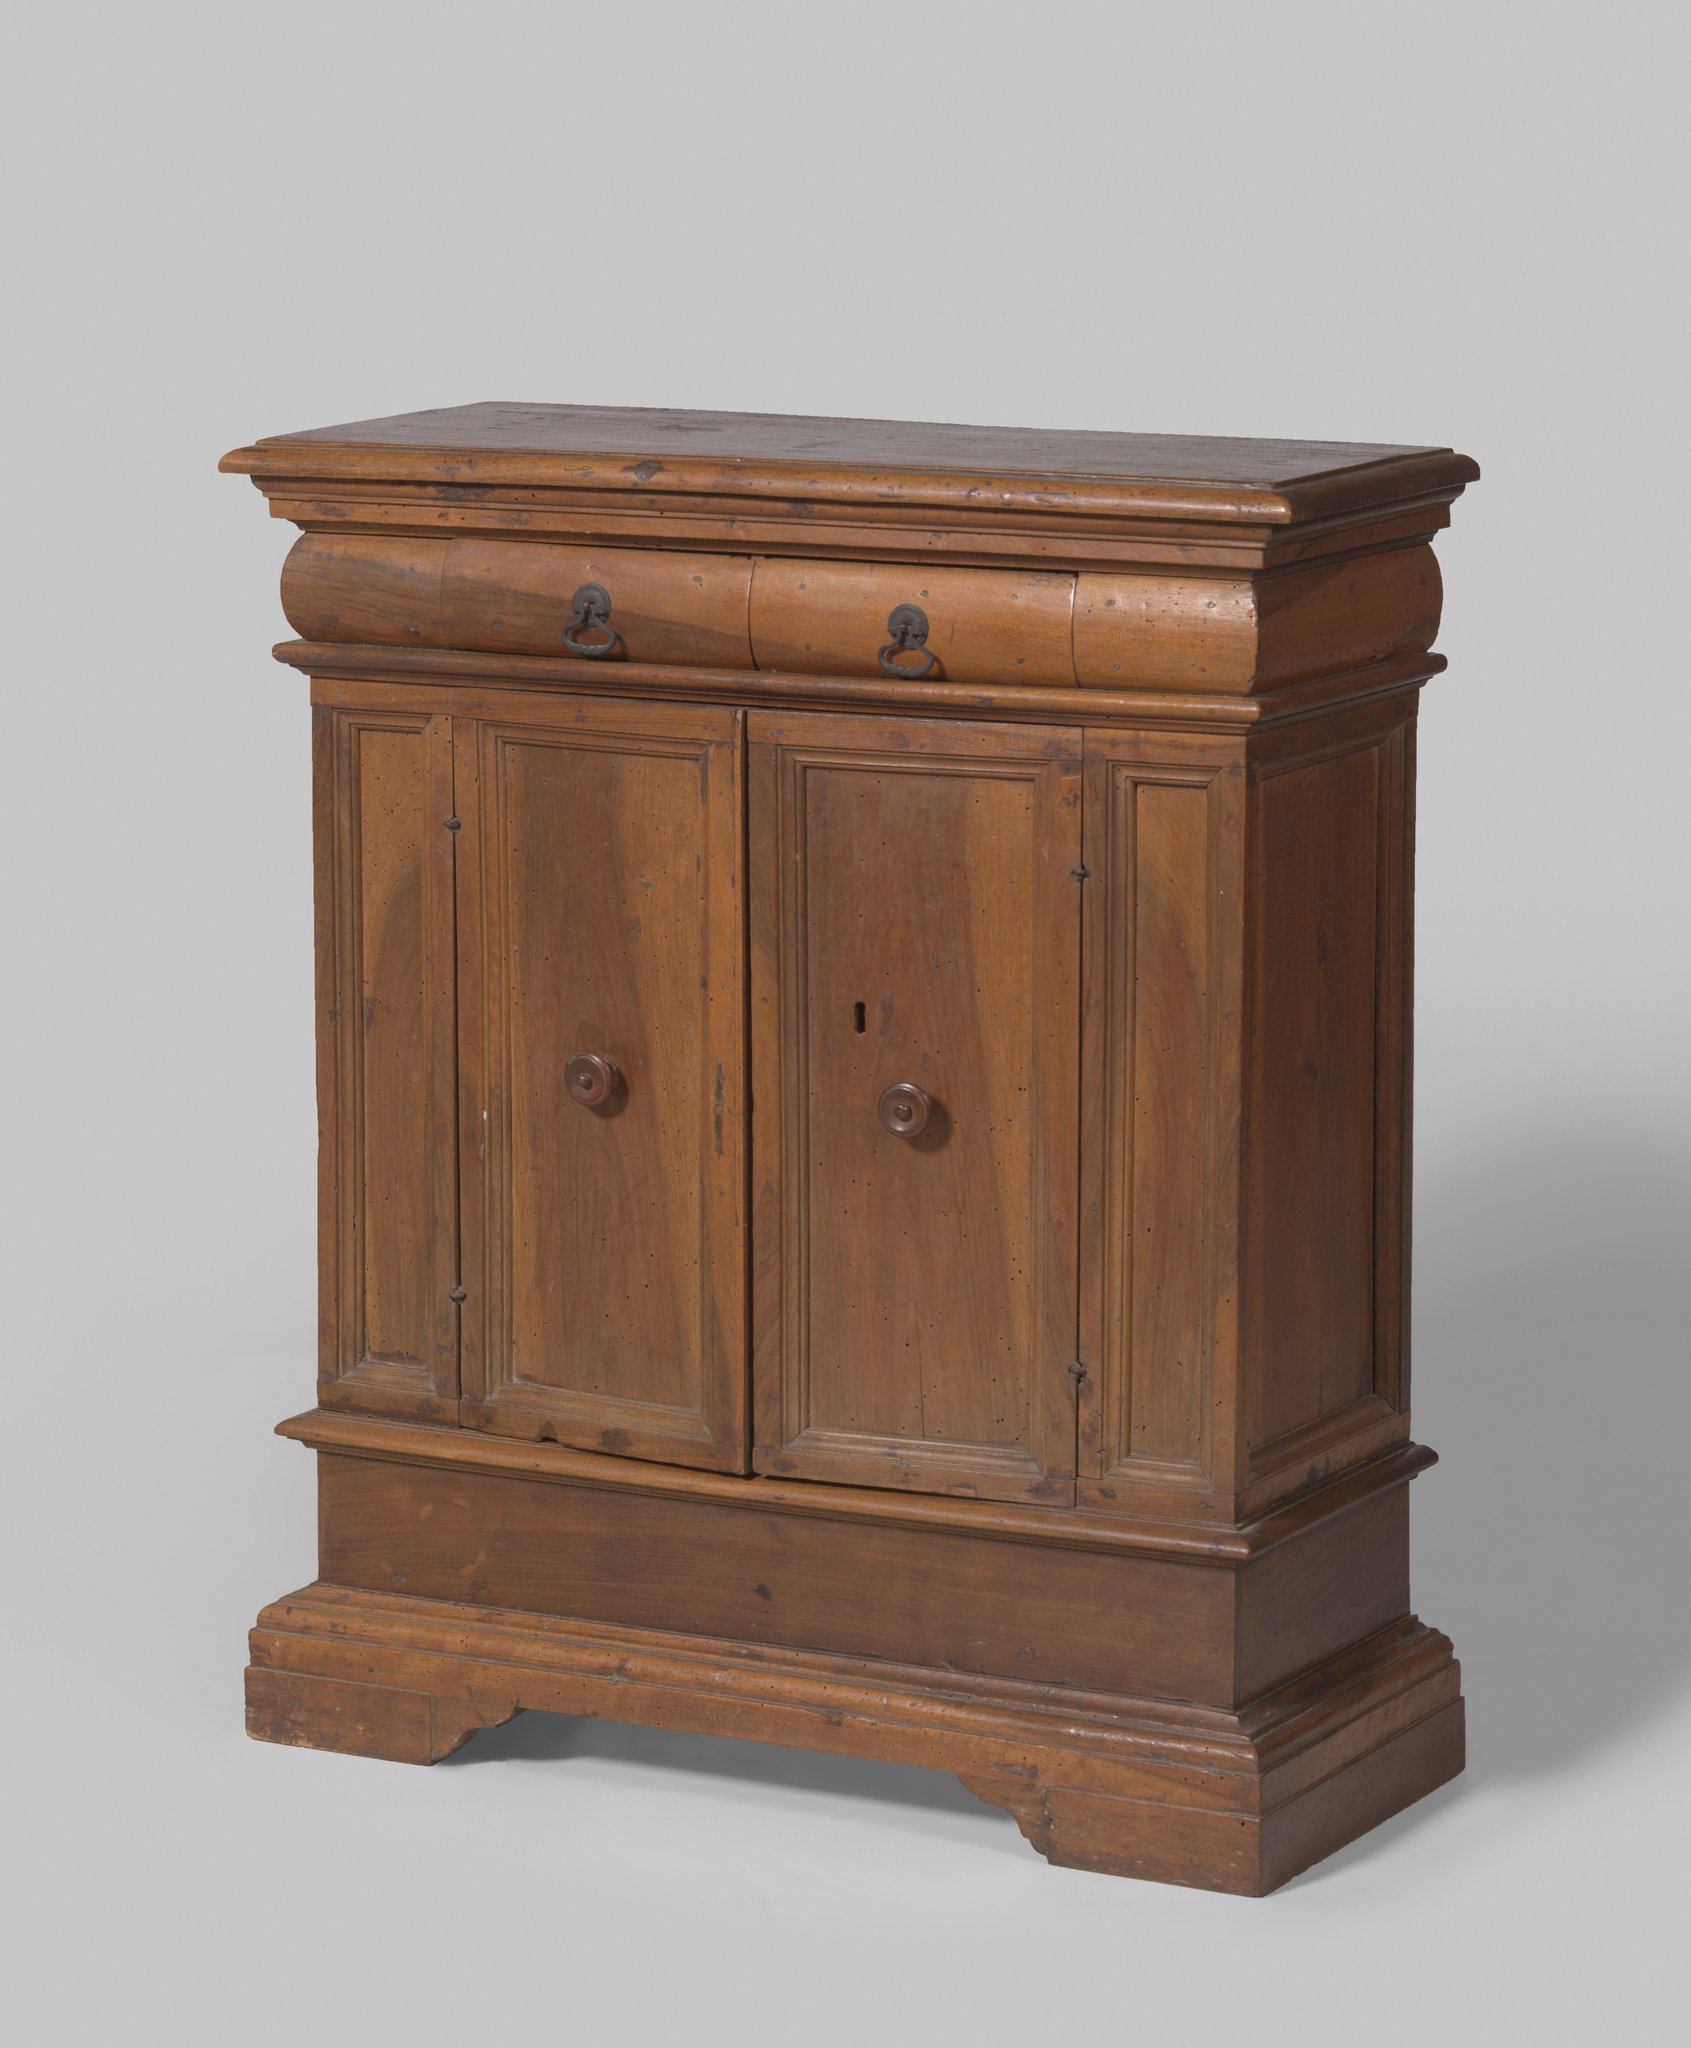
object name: furniture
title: Kast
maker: Anonymous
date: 1500-1600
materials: wood, iron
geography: italy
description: Kast van noten- en populierenhout op doorlopend, veelvuldig geprofileerd onderstel, waarvan aan de voorkant de onderste plint in het midden onderbroken is. Het bovenstel heeft onder de rijk geprofileerde dekplaat een ruimte voor laden met convex profiel, waarin twee laadjes naast elkaar, ieder met een ijzeren handvat. De kastruimte, ingesloten tussen twee enkelvoudig geprofileerde vloeren, bevat vier compartimenten.